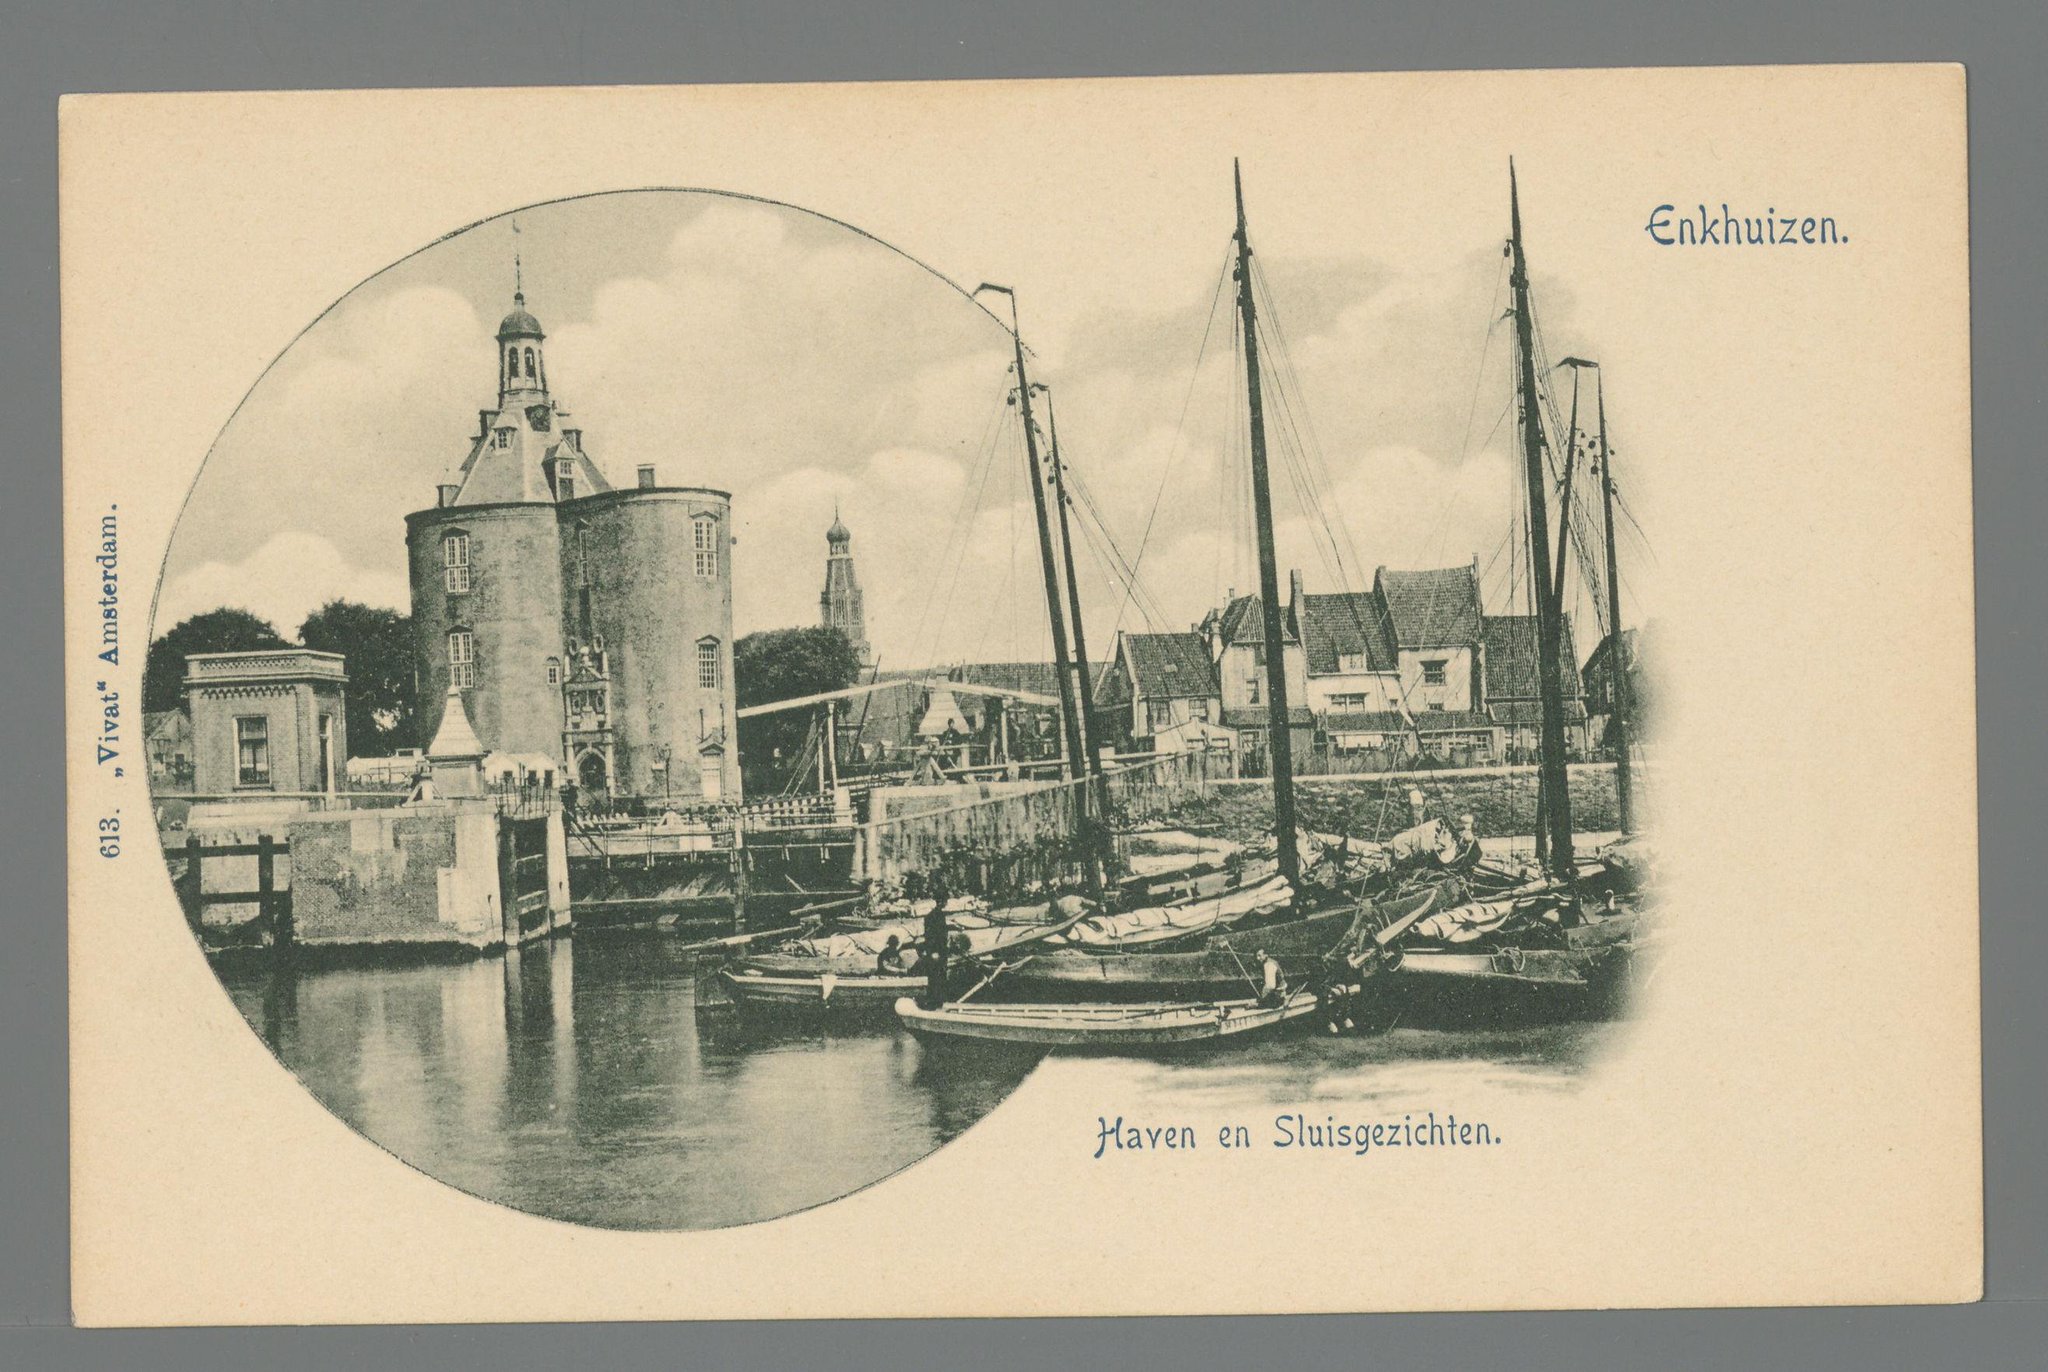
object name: ansichtkaart, prentbriefkaart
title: Enkhuizen. Haven en sluisgezichten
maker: Anonymous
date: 1892-1905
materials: cardboard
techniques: photograph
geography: enkhuizen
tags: harbour, city-view, and landscape with man-made constructions, sailing-ship, sailing-boat, city-gate, enkhuizen